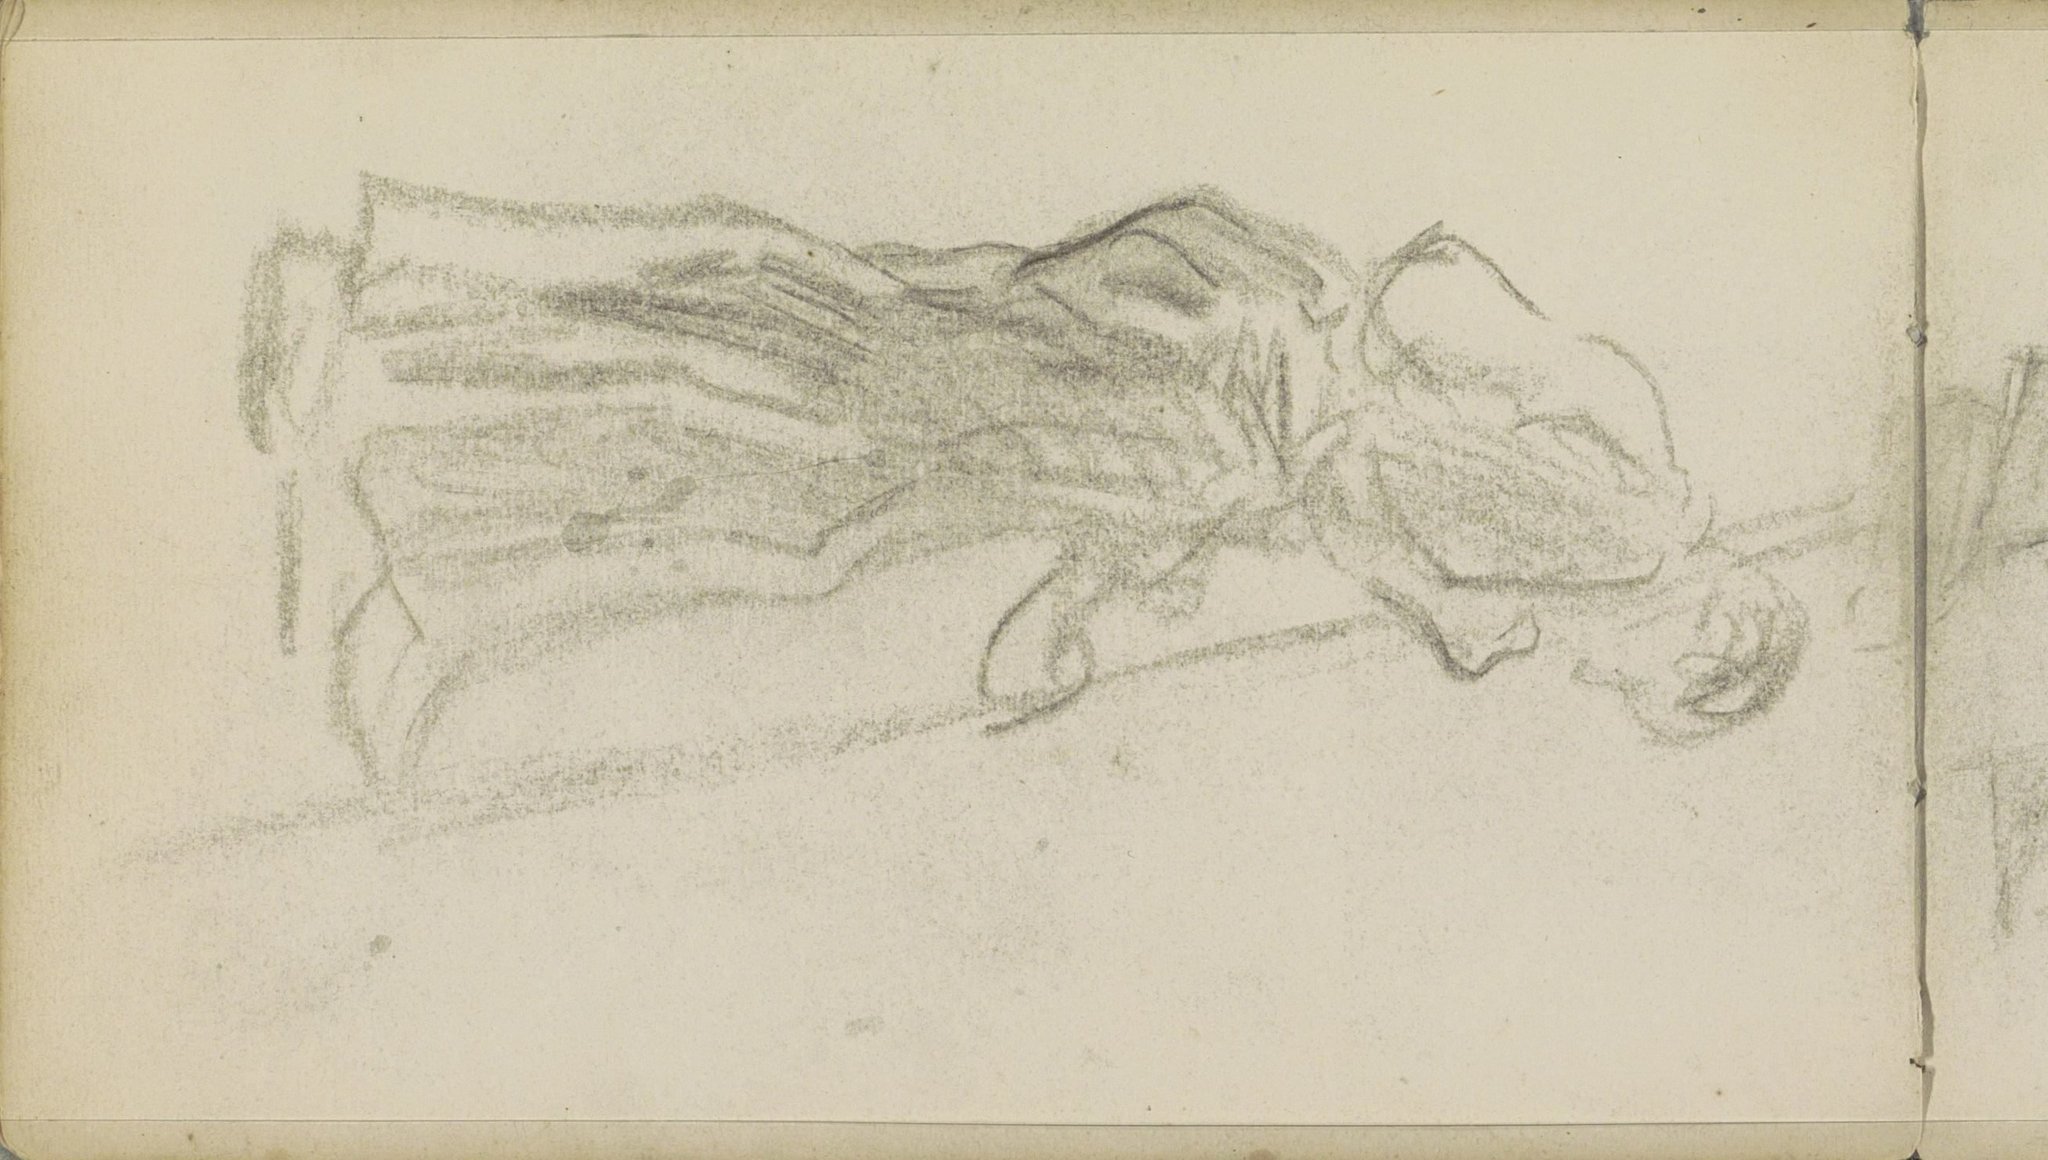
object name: sketchbook leaf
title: Man met een stuk landbouwgereedschap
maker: jozef israëls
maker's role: draughtsman, painter, print maker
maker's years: 1824-1911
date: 1834-1911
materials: chalk, paper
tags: agricultural implements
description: Vermoedelijk een arbeider met een schoffel. Blad 5 verso uit een schetsboek met 42 bladen.